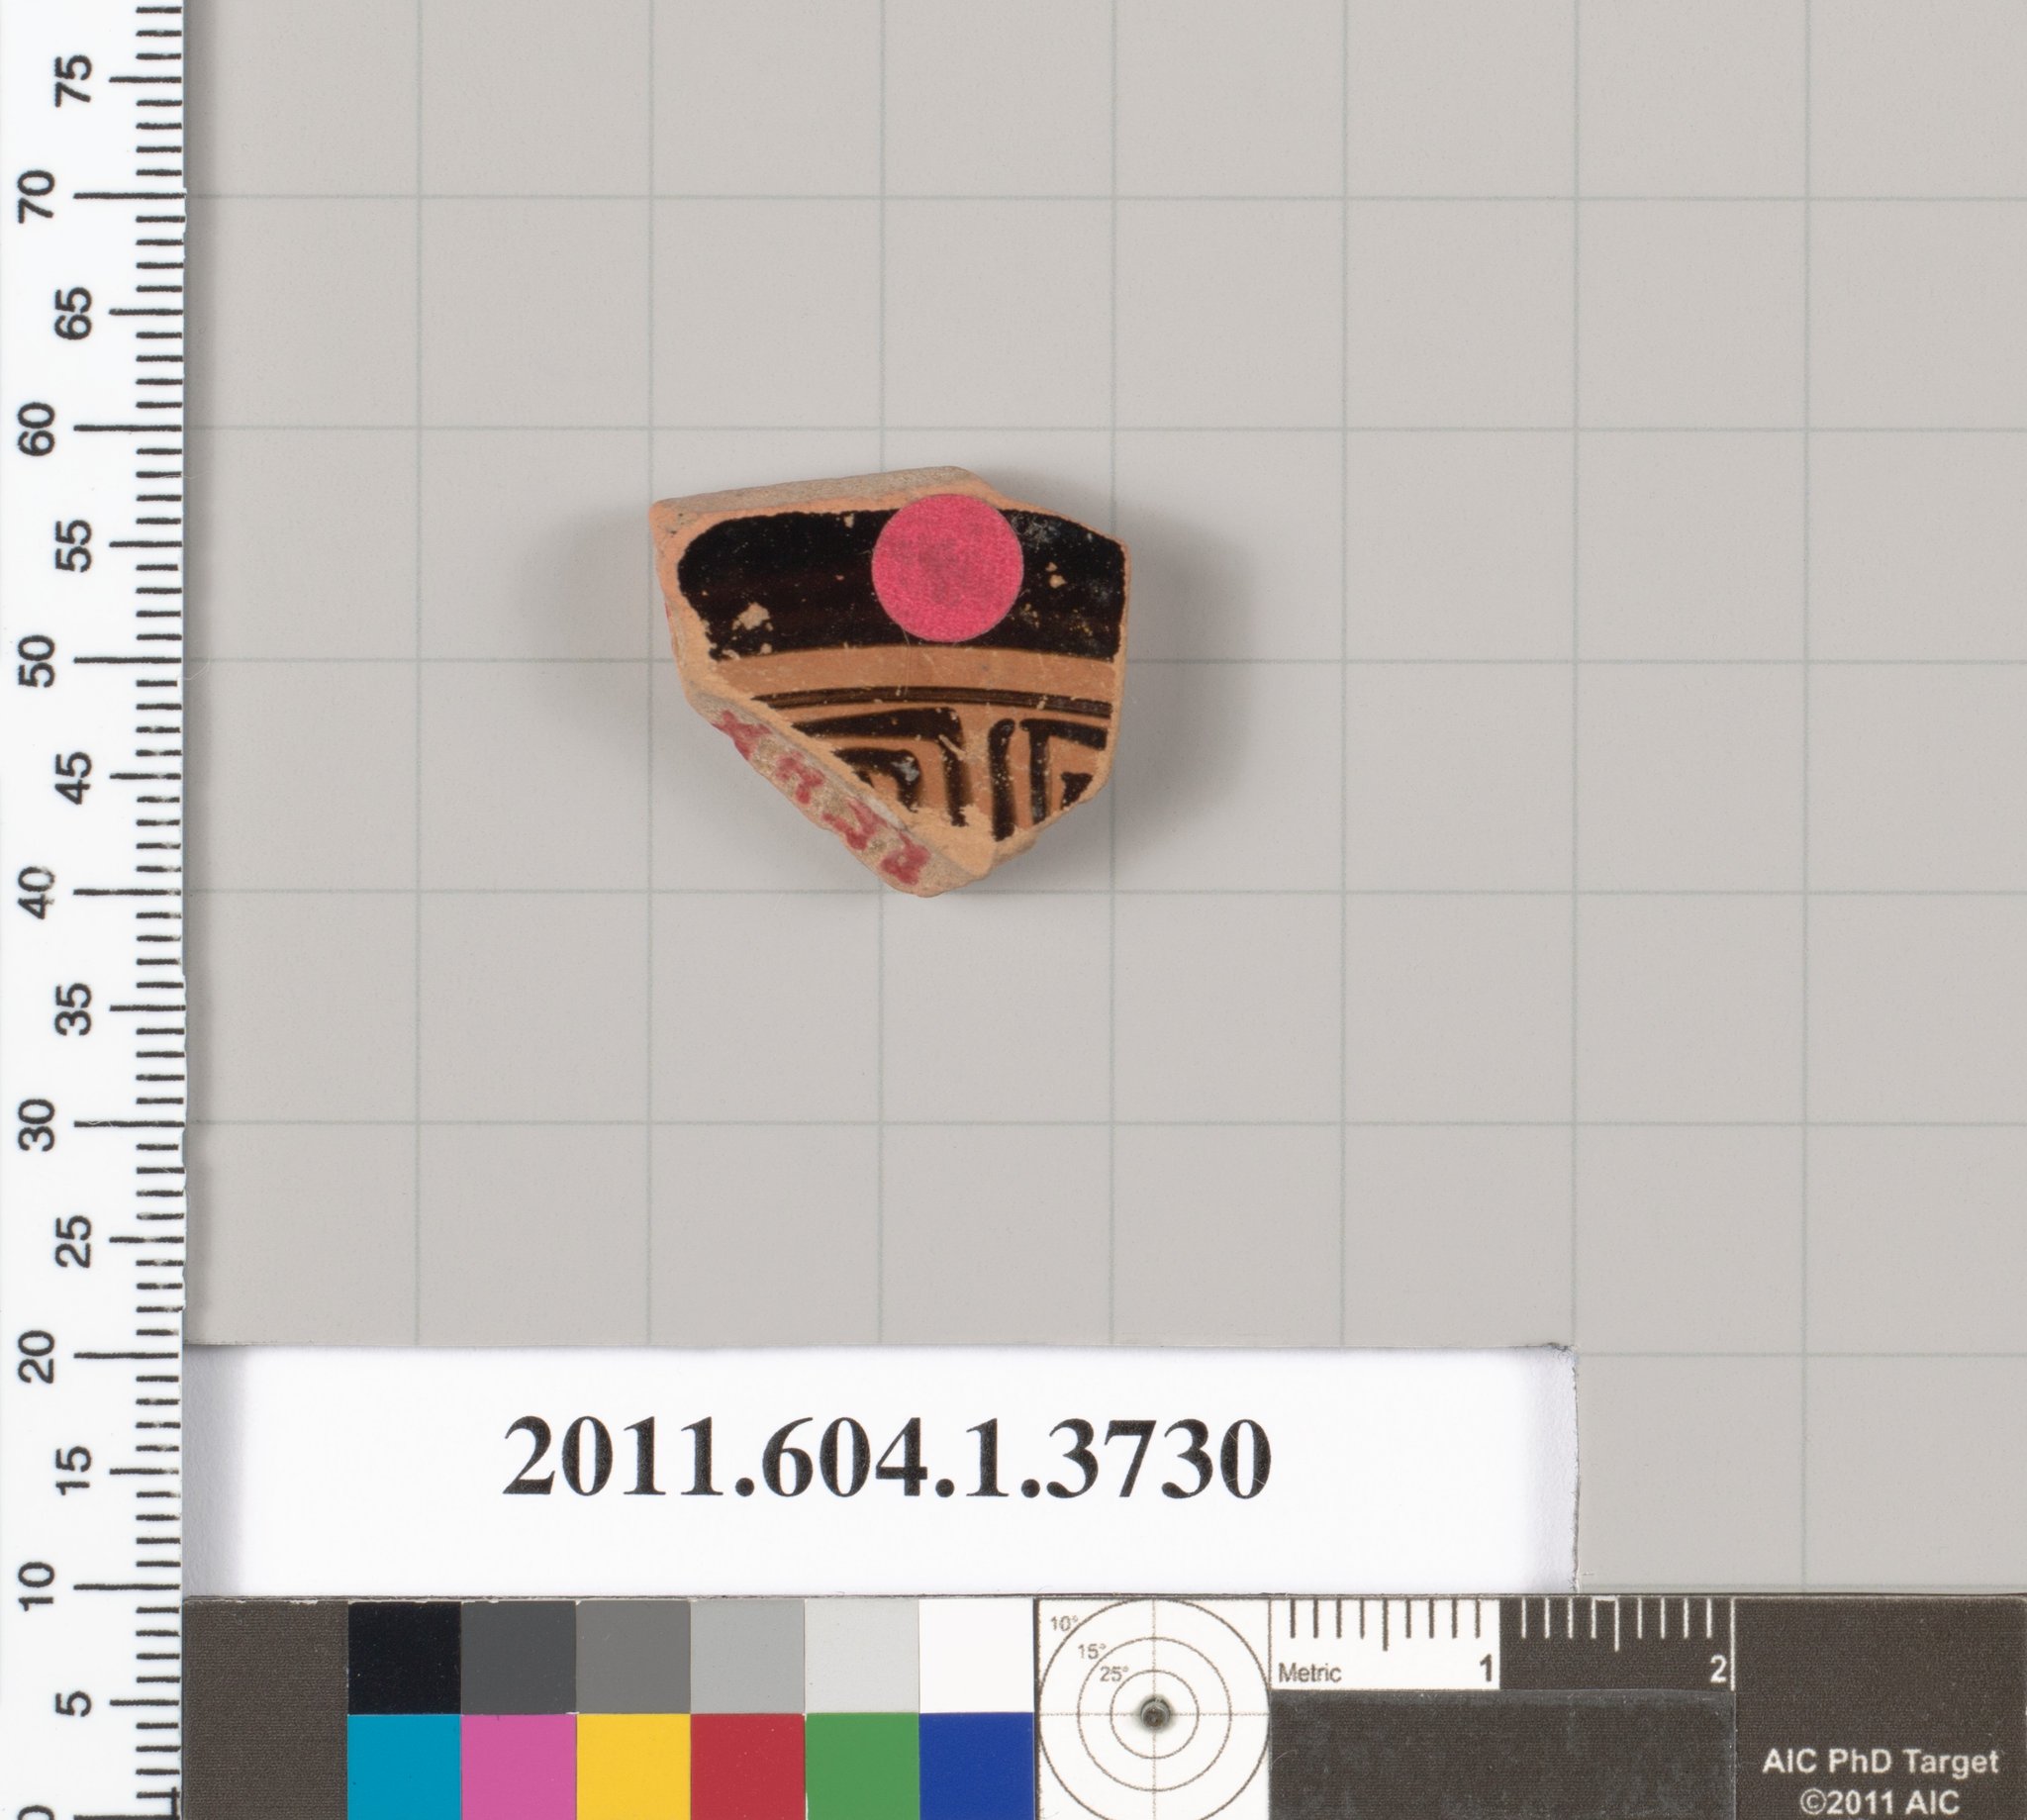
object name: kylix fragment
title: Terracotta fragment of a kylix (drinking cup)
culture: greek, attic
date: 475-451 BCE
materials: terracotta